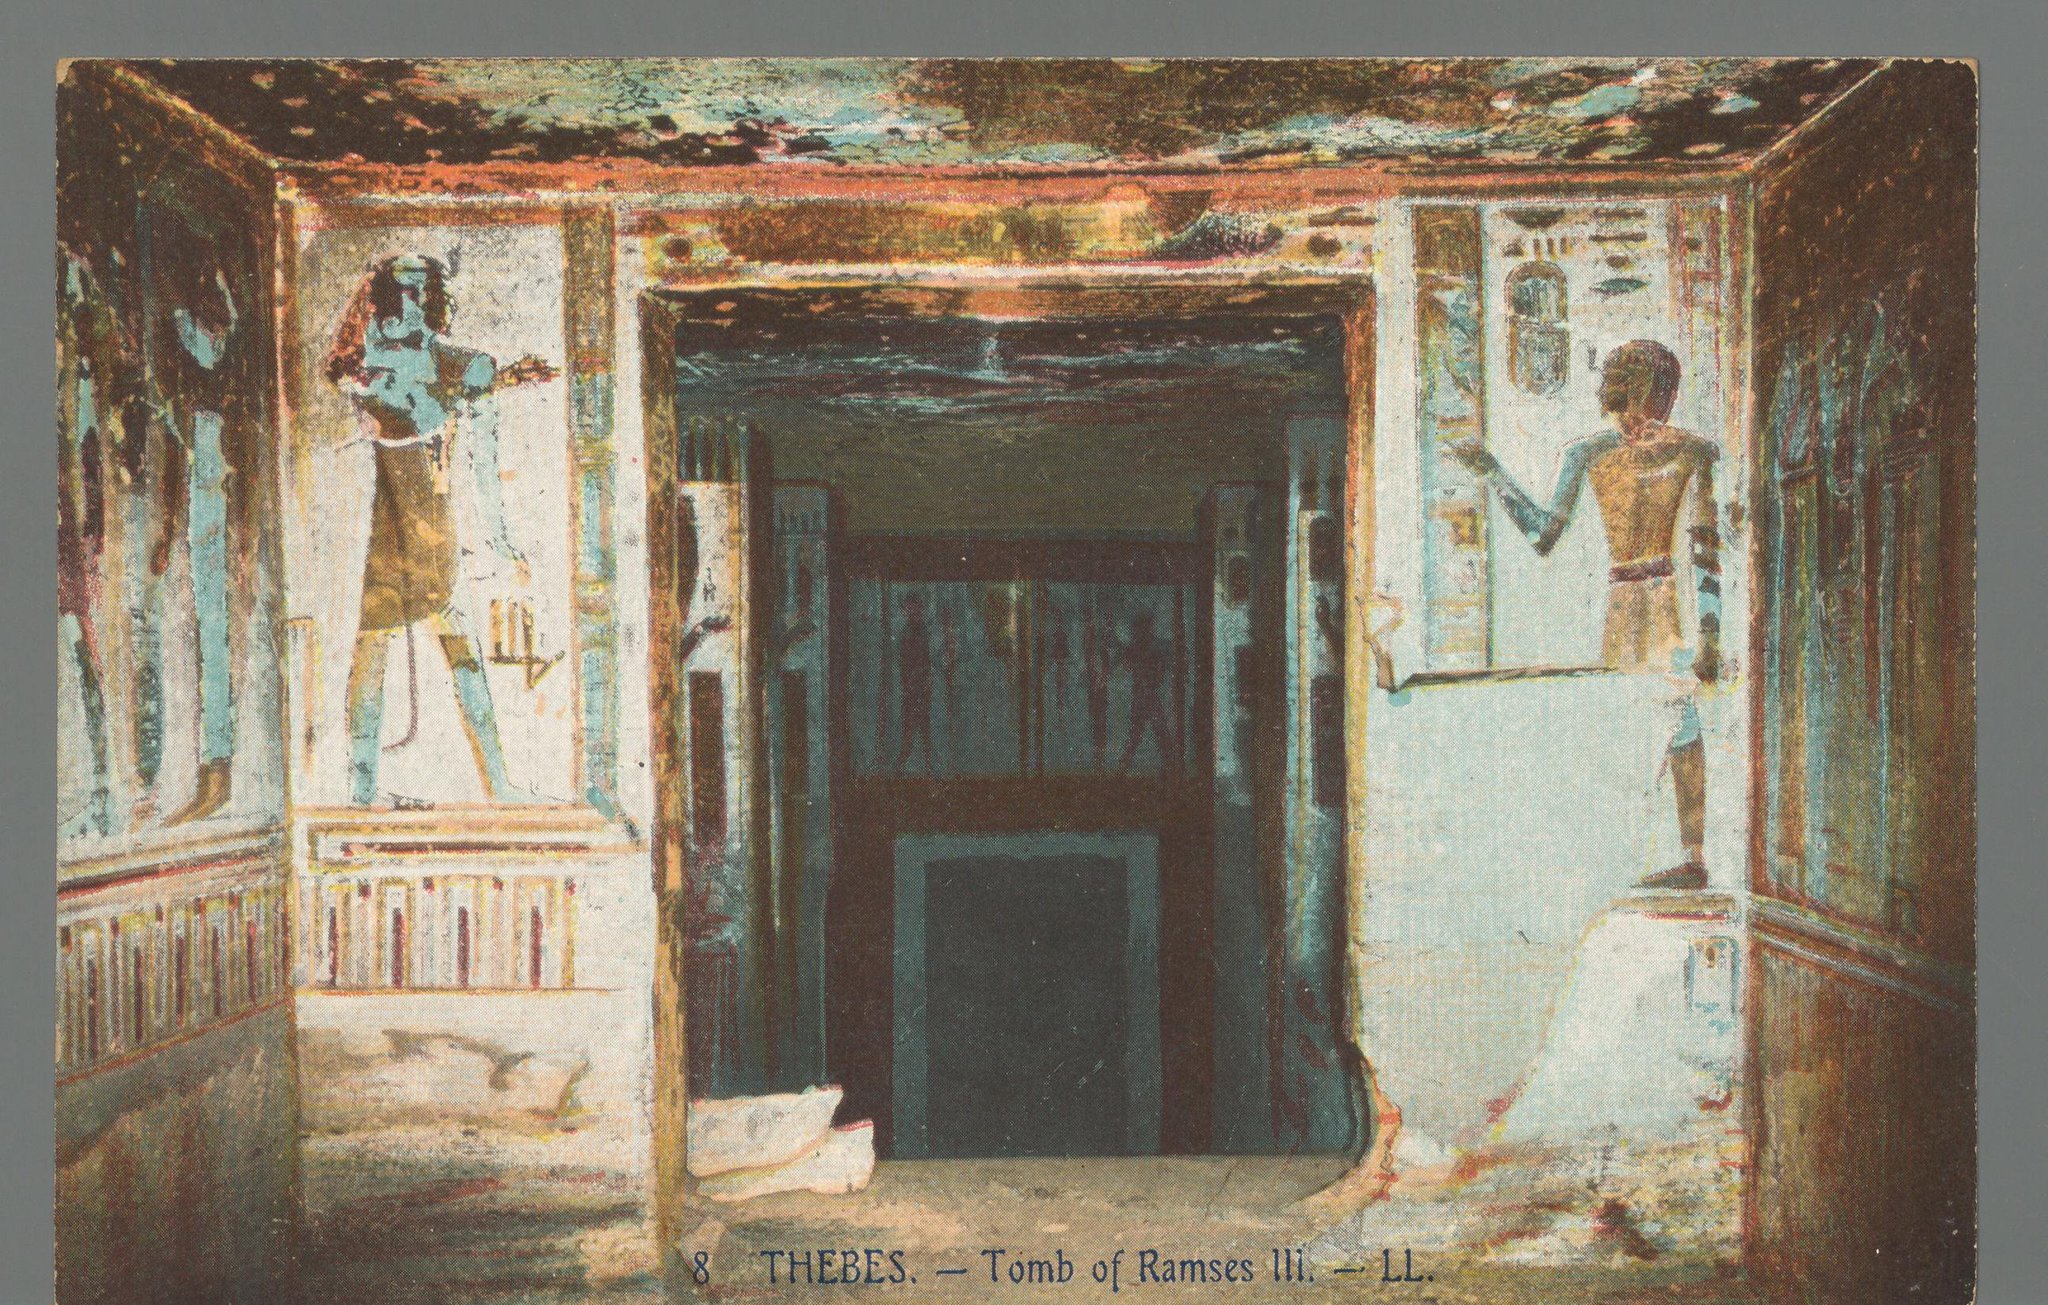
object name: ansichtkaart, prentbriefkaart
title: Thebes - Tomb of Ramses III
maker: Anonymous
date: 1907-1930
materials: cardboard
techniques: lithograph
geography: medinet habu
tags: temple, shrine ~ egyptian religion, grave-building, monumental tomb